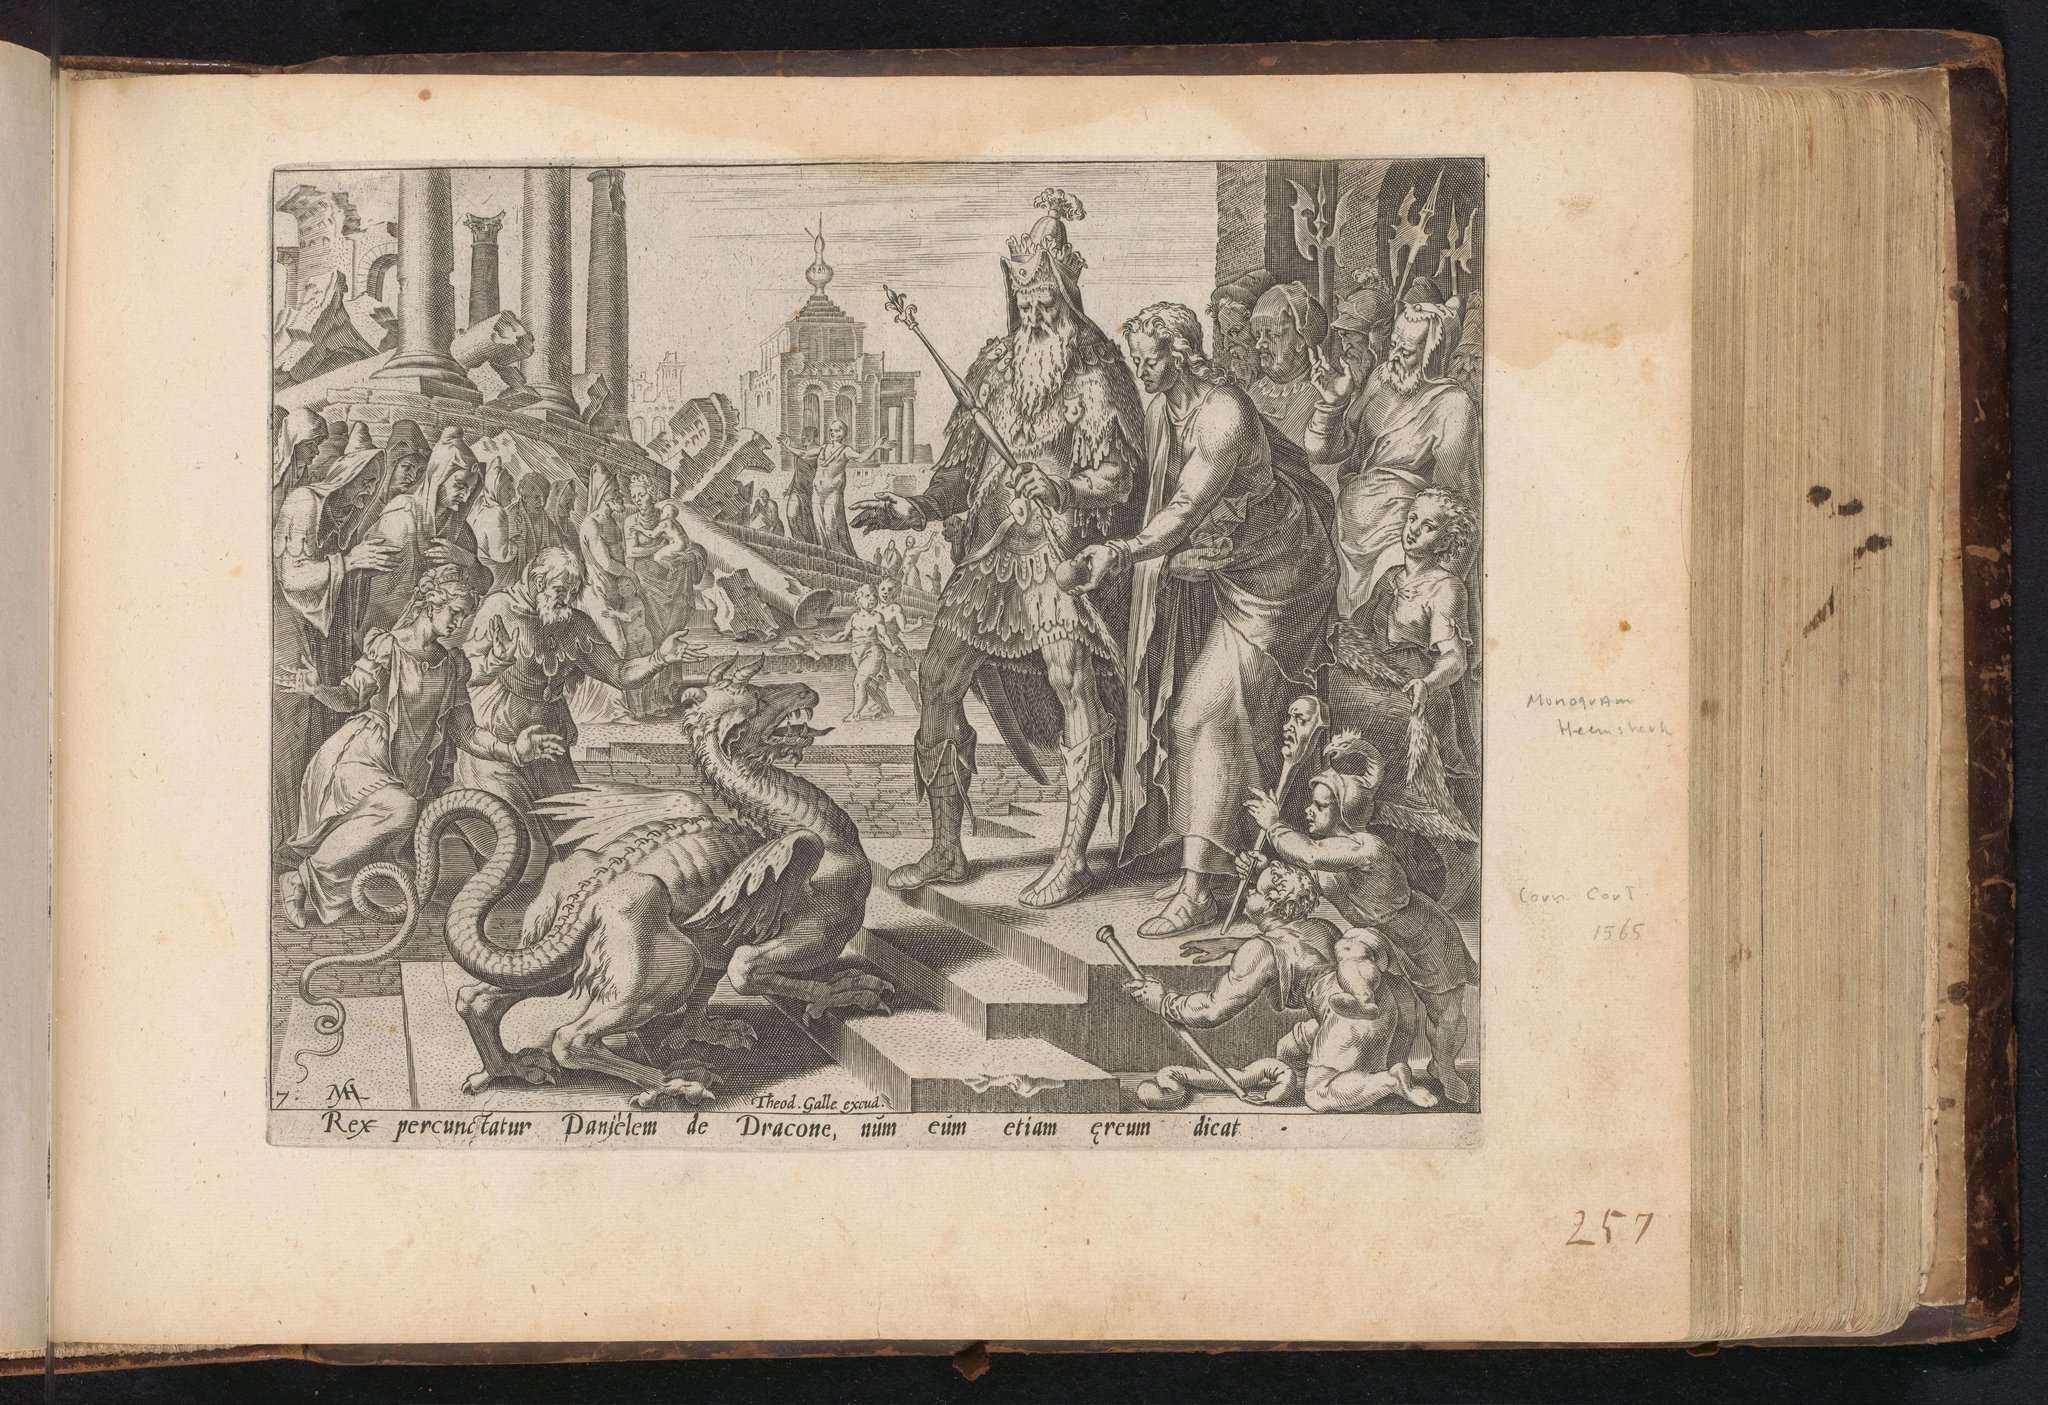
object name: album leaf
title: Geschiedenis van Daniël, Bel en de draak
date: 1565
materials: paper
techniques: engraving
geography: alkmaar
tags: daniel gives food to the dragon; king cyrus looking on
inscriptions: number: ‘257’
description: Koning Cyrus vraagt Daniël om de draak als god te vereren. Daniël weigert dit en vraagt toestemming om de draak te doden zonder het gebruik van wapens. Hij voedt de draak met koeken van teer, vet en graten die de draak van binnen openrijten. Onder de voorstelling een verklarende tekst in het Latijn. Prent maakt deel uit van een album.